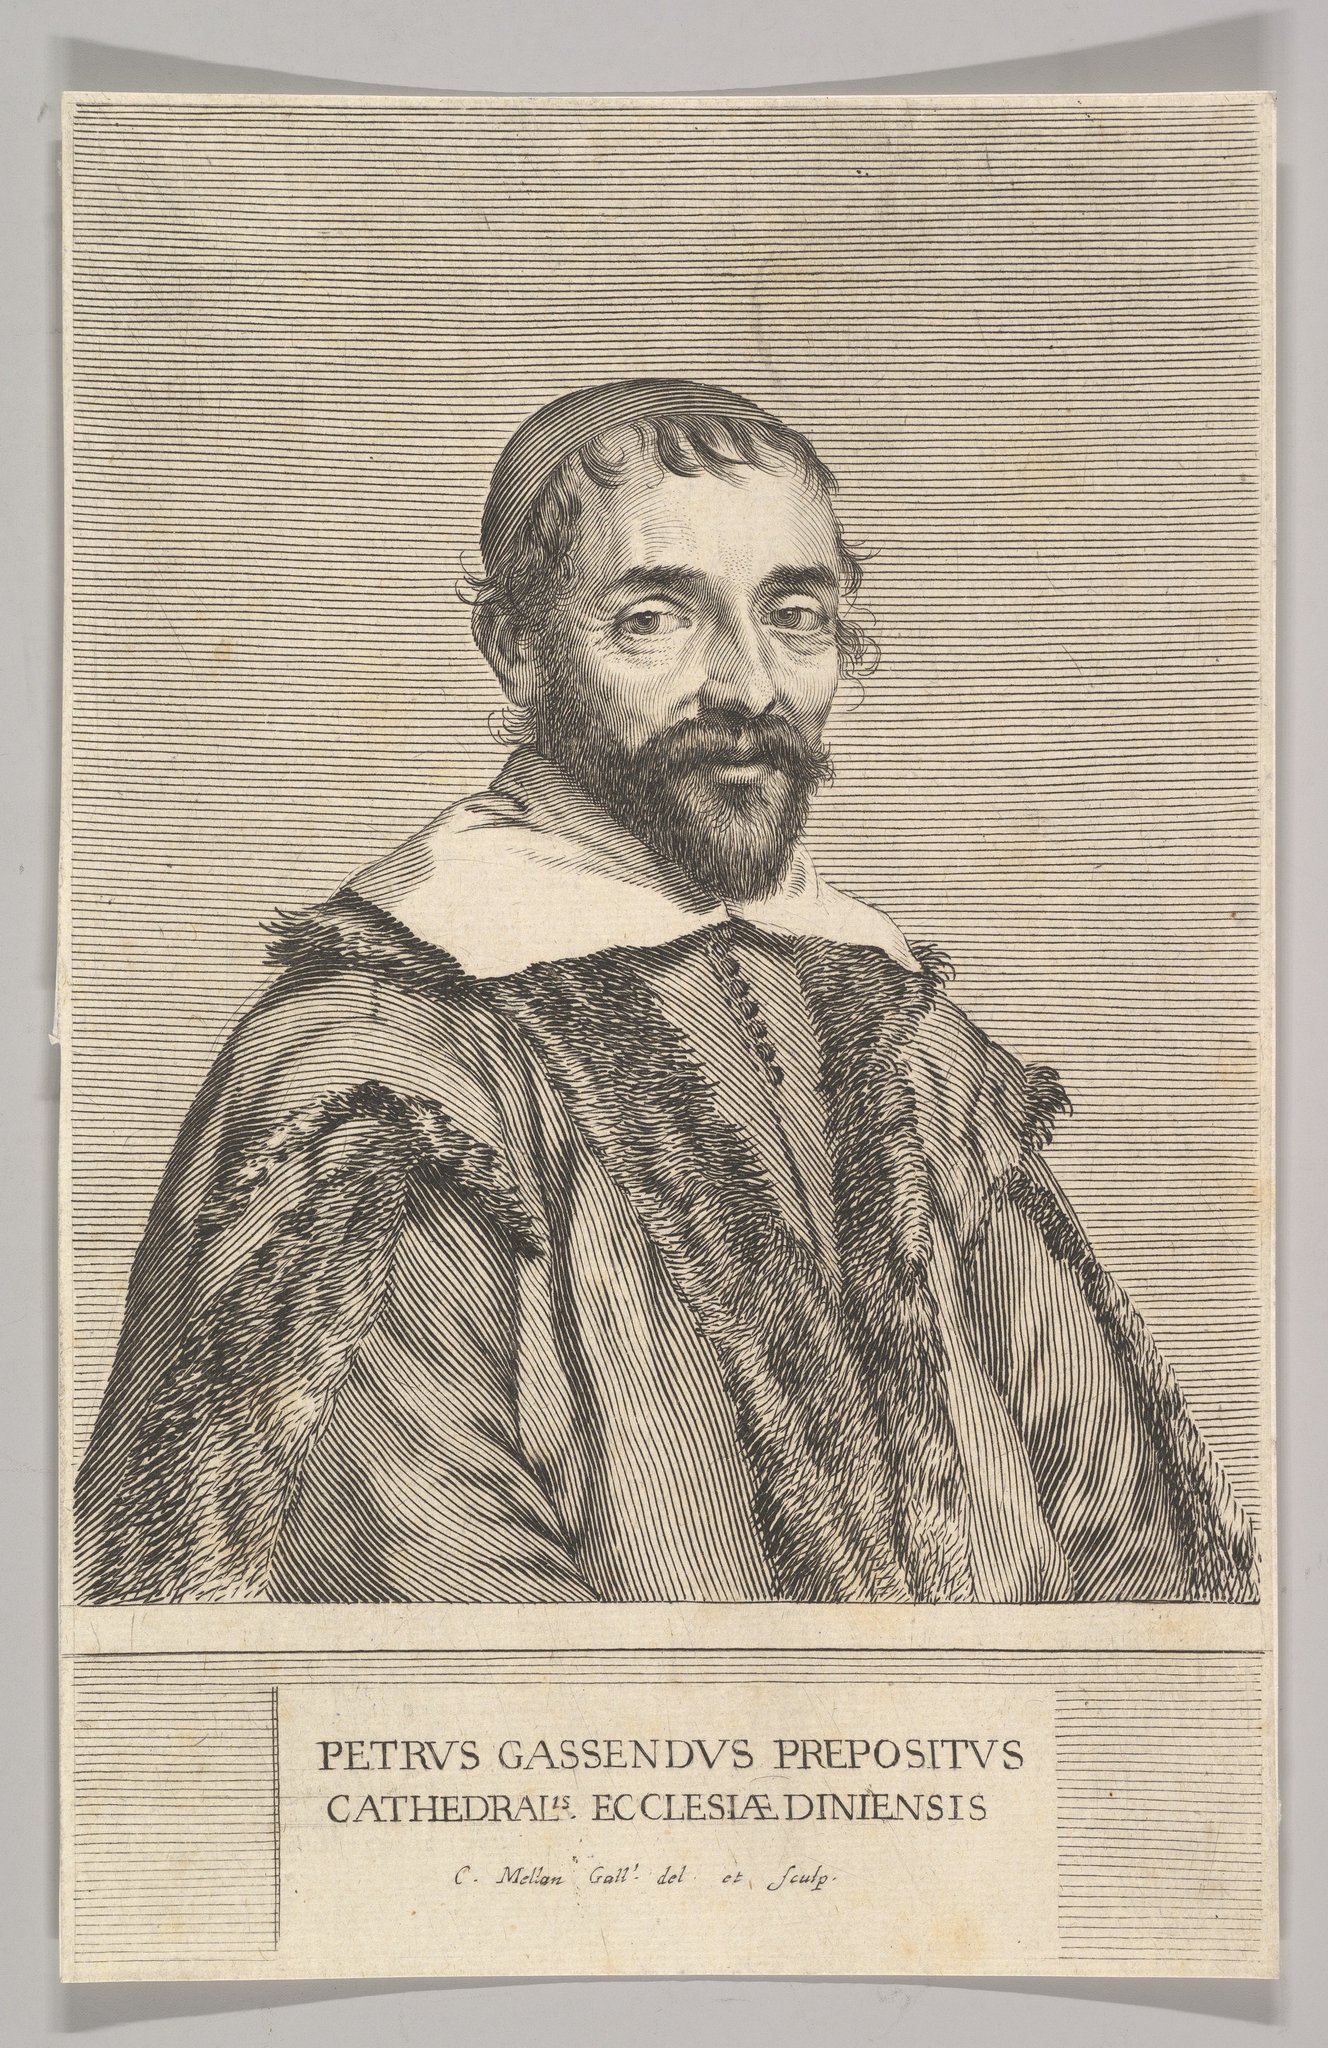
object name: print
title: Pierre Gassendi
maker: claude mellan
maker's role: artist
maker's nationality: french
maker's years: 1598-1688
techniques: engraving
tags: men,portraits